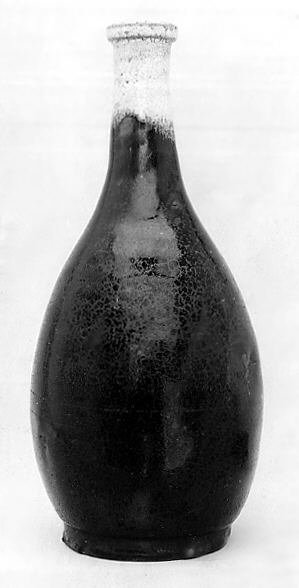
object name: bottle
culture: japanese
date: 1701-1800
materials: clay, glaze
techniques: overglaze